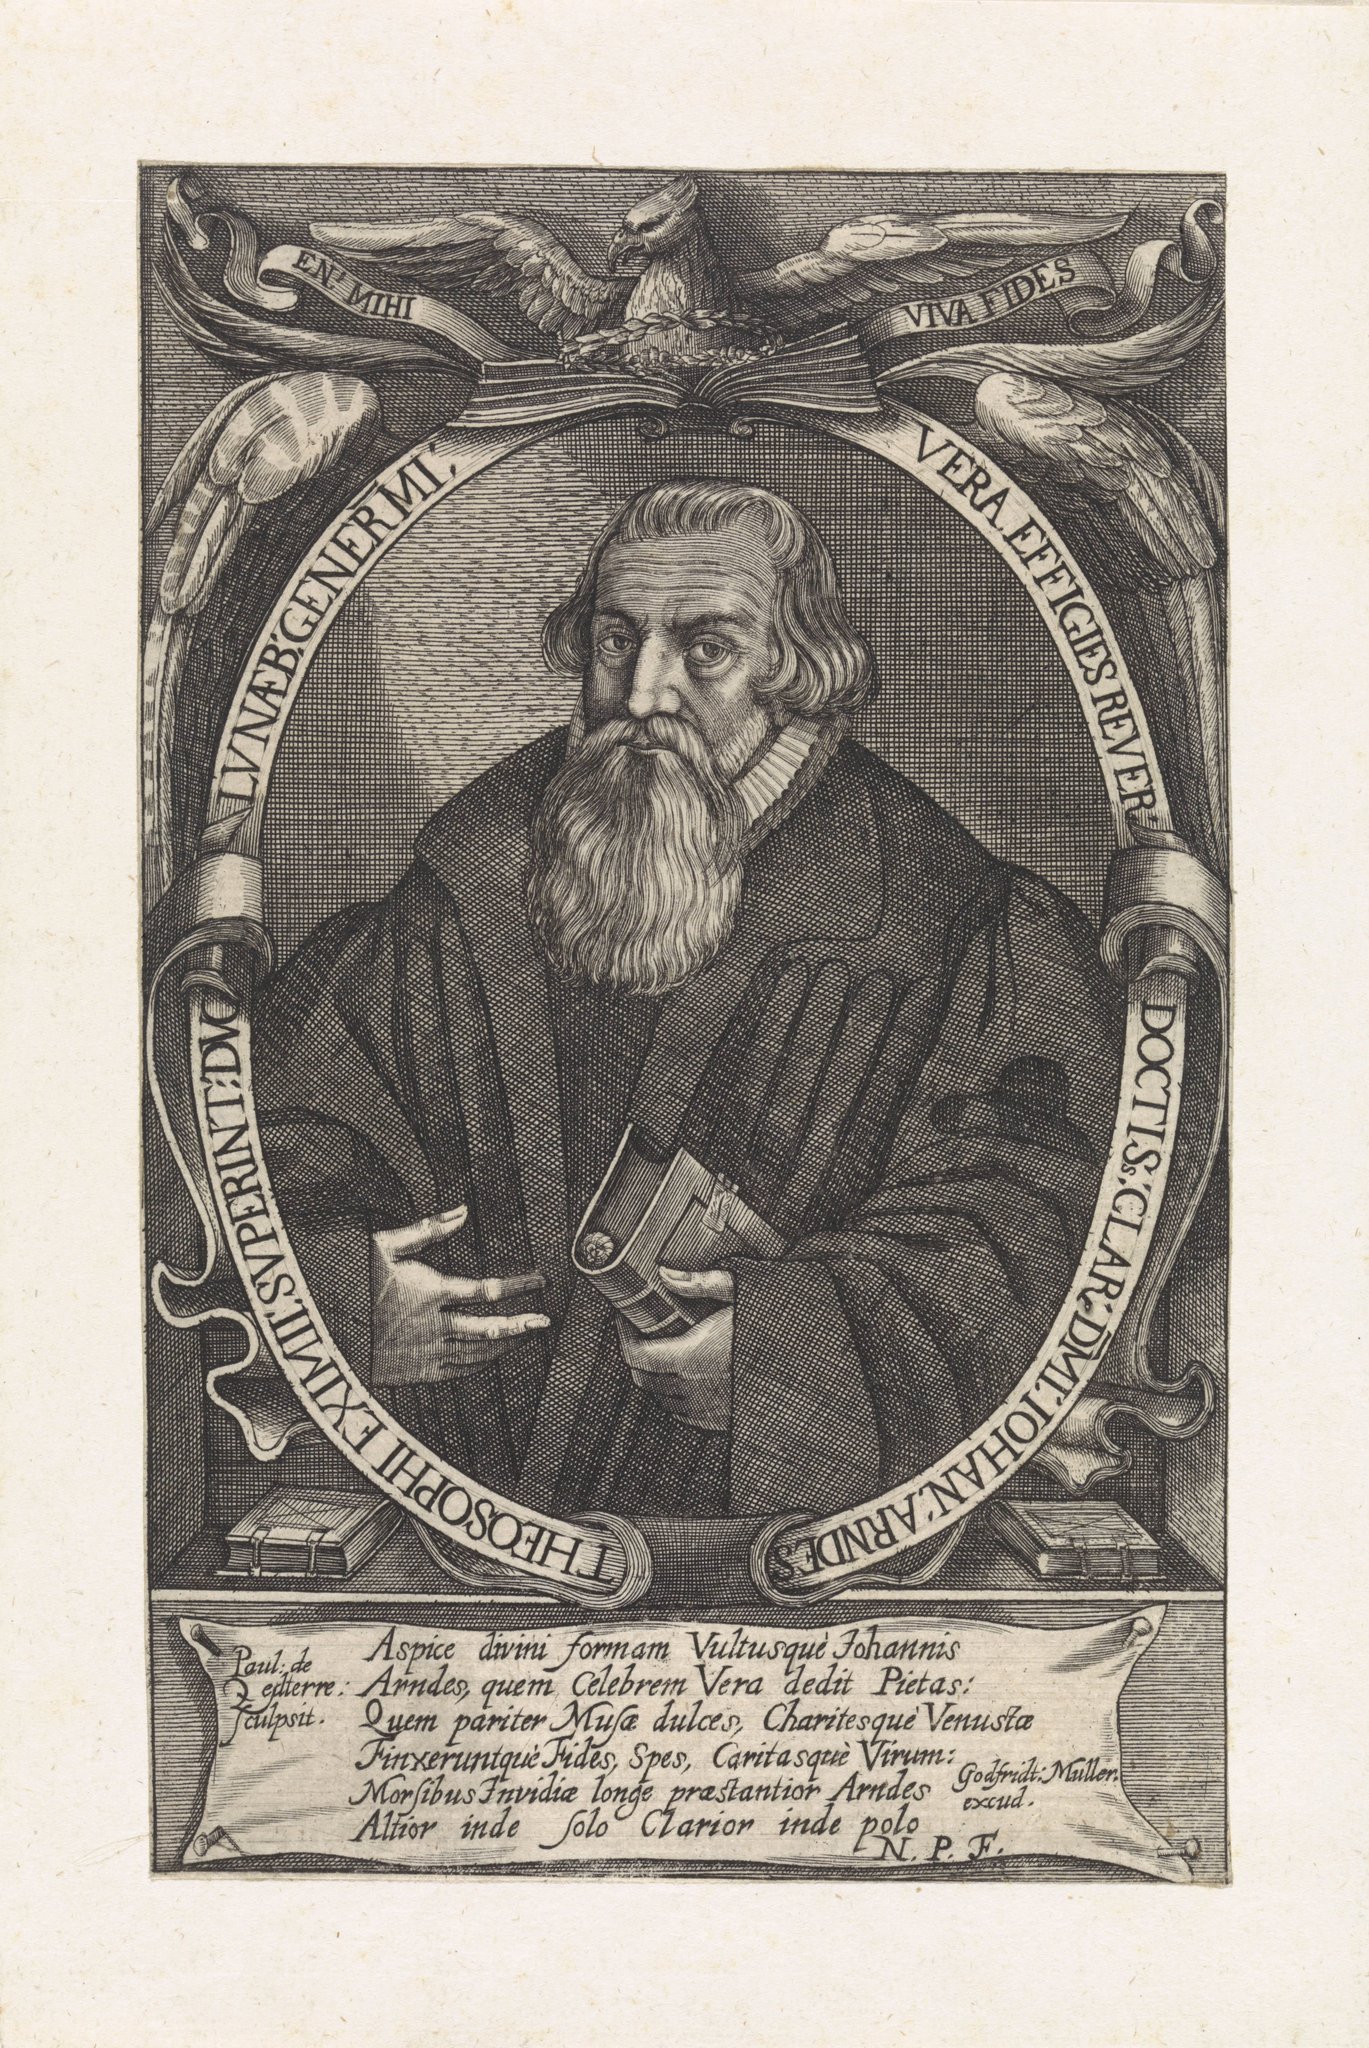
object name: print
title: Portret van Johann Arndt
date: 1610-1667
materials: paper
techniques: engraving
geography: germany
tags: edderitz, celle, theoloog, johann arndt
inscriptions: collector's mark: Lugt 2228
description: Portret van de theoloog Johann Arndt met de bijbel in zijn hand in een ovale ornamentele lijst. Onderaan een zesregelige tekst in het Latijn.